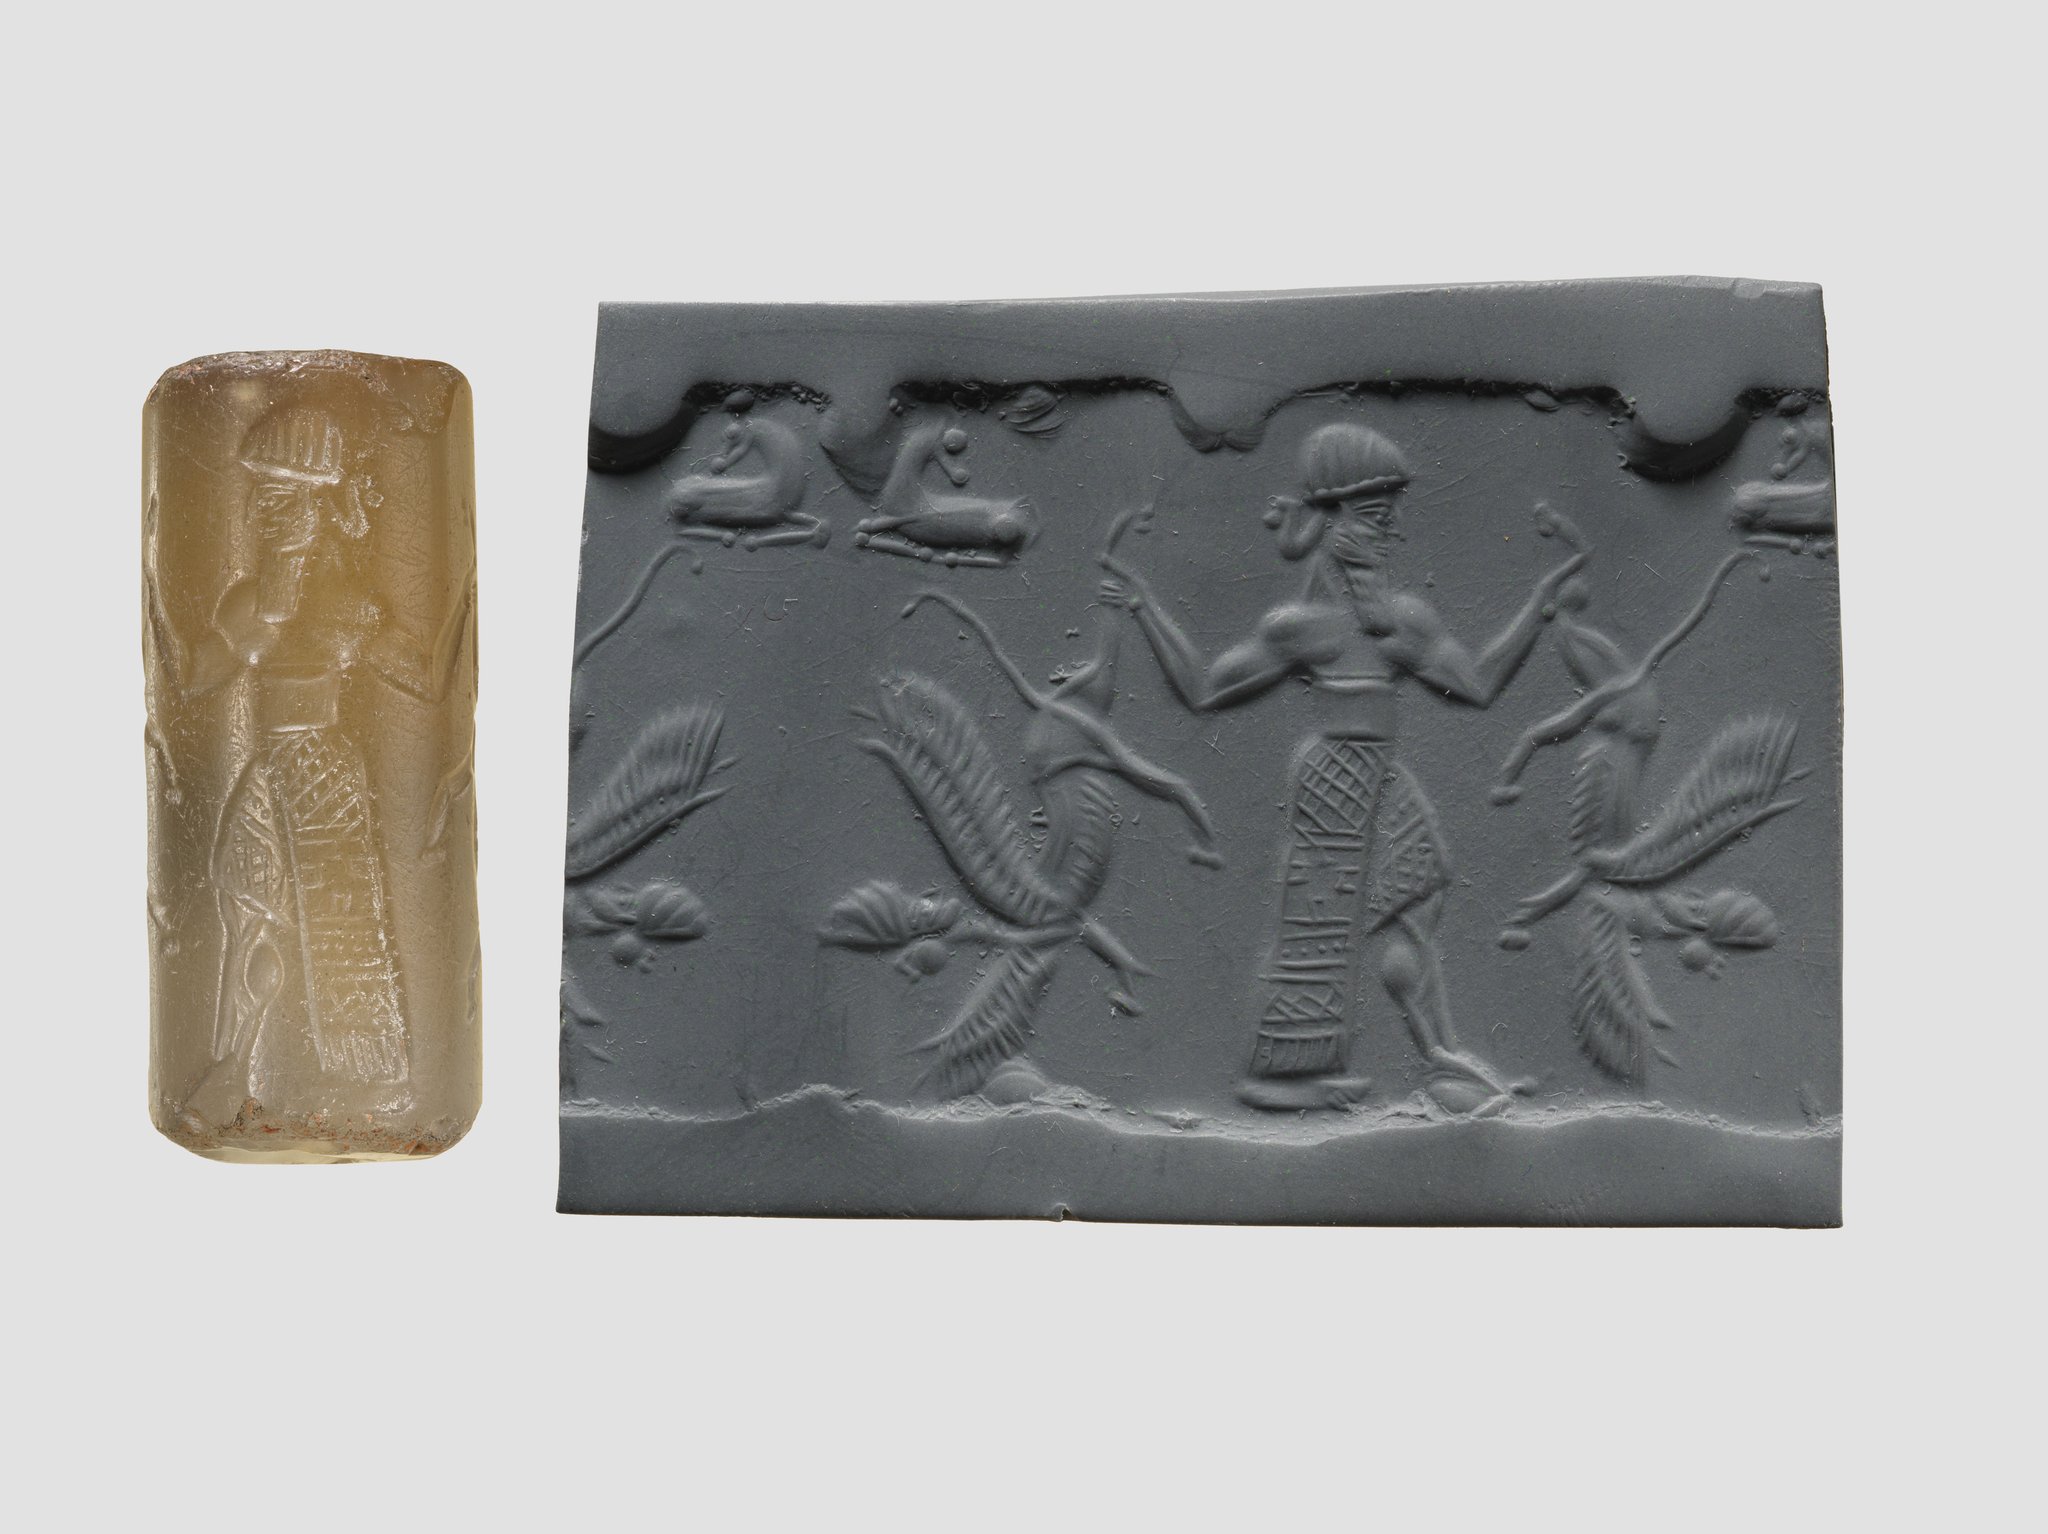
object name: cylinder seal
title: Cylinder seal with three-figure contest scene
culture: babylonian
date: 734-701 BCE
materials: stone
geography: mesopotamia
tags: men